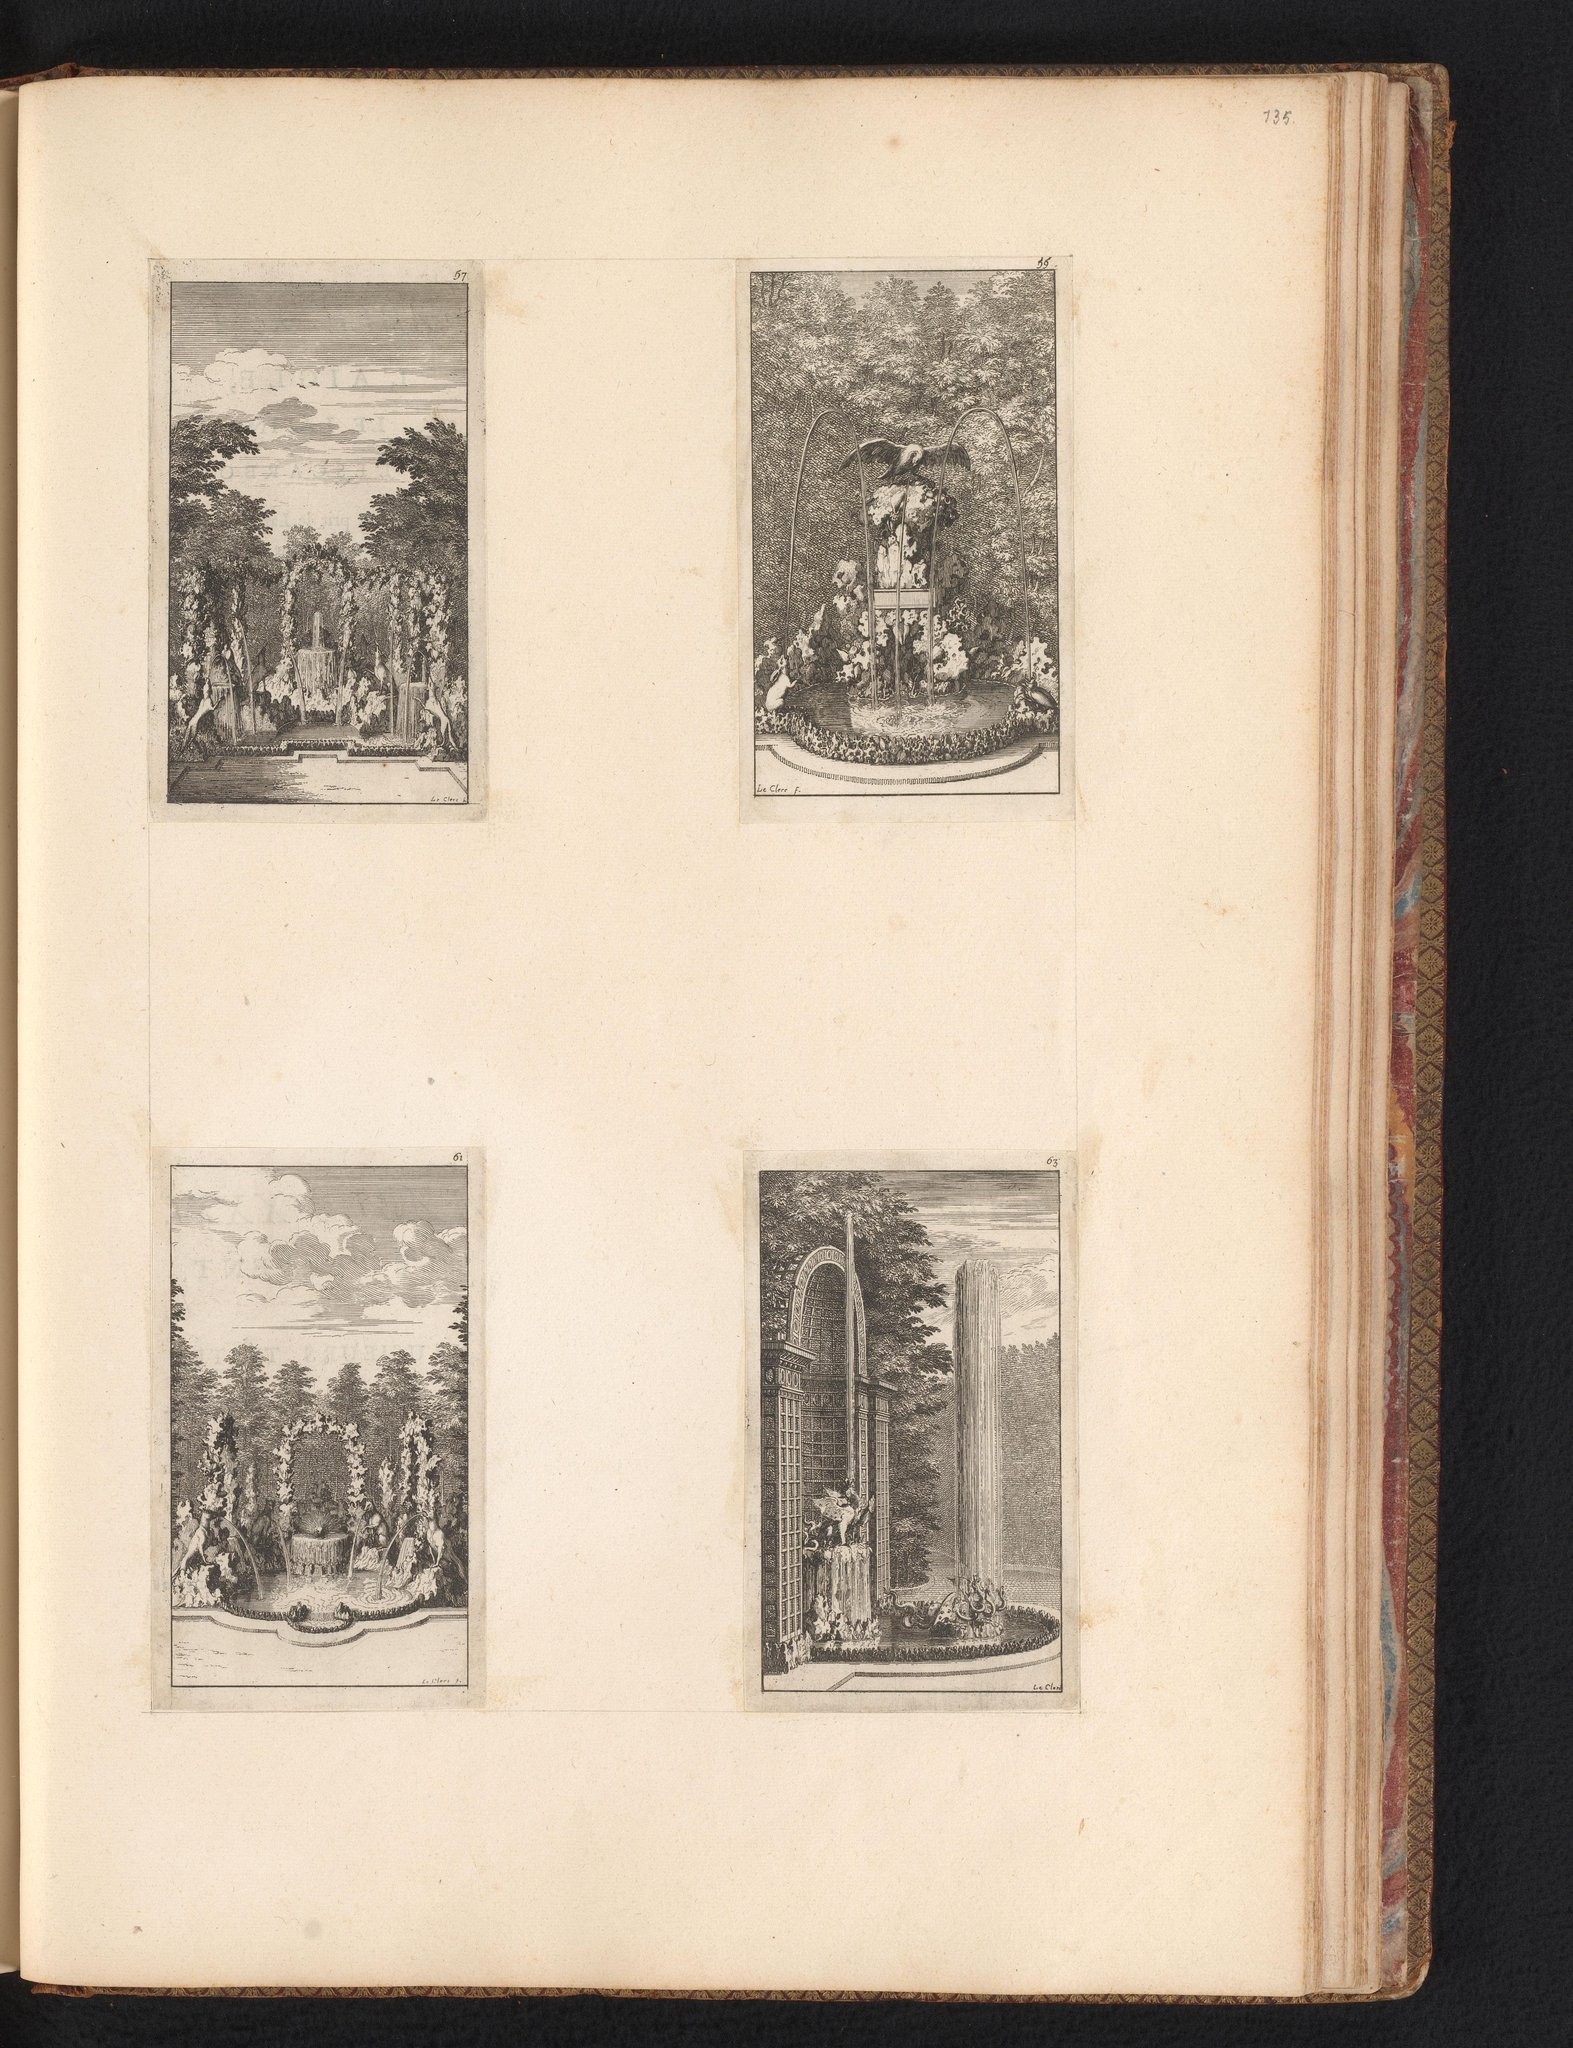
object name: album leaf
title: Vier gezichten op het labyrint van het Paleis van Versailles met fonteinen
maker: sébastien leclerc (i)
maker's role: print maker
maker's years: 1637-1714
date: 1677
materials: paper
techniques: etching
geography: paris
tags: garden fountain, fables of aesop : use 85(...), labyrinth, maze ~ garden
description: Prenten uit: Perrault, Charles. Labyrinthe de Versailles. Parijs: Imprimerie Royale, 1677. Hierin staan veertig prenten van het labyrint in de tuin van het Paleis van Versailles met verschillende fonteinen gebaseerd op de fabels van Aesopus.